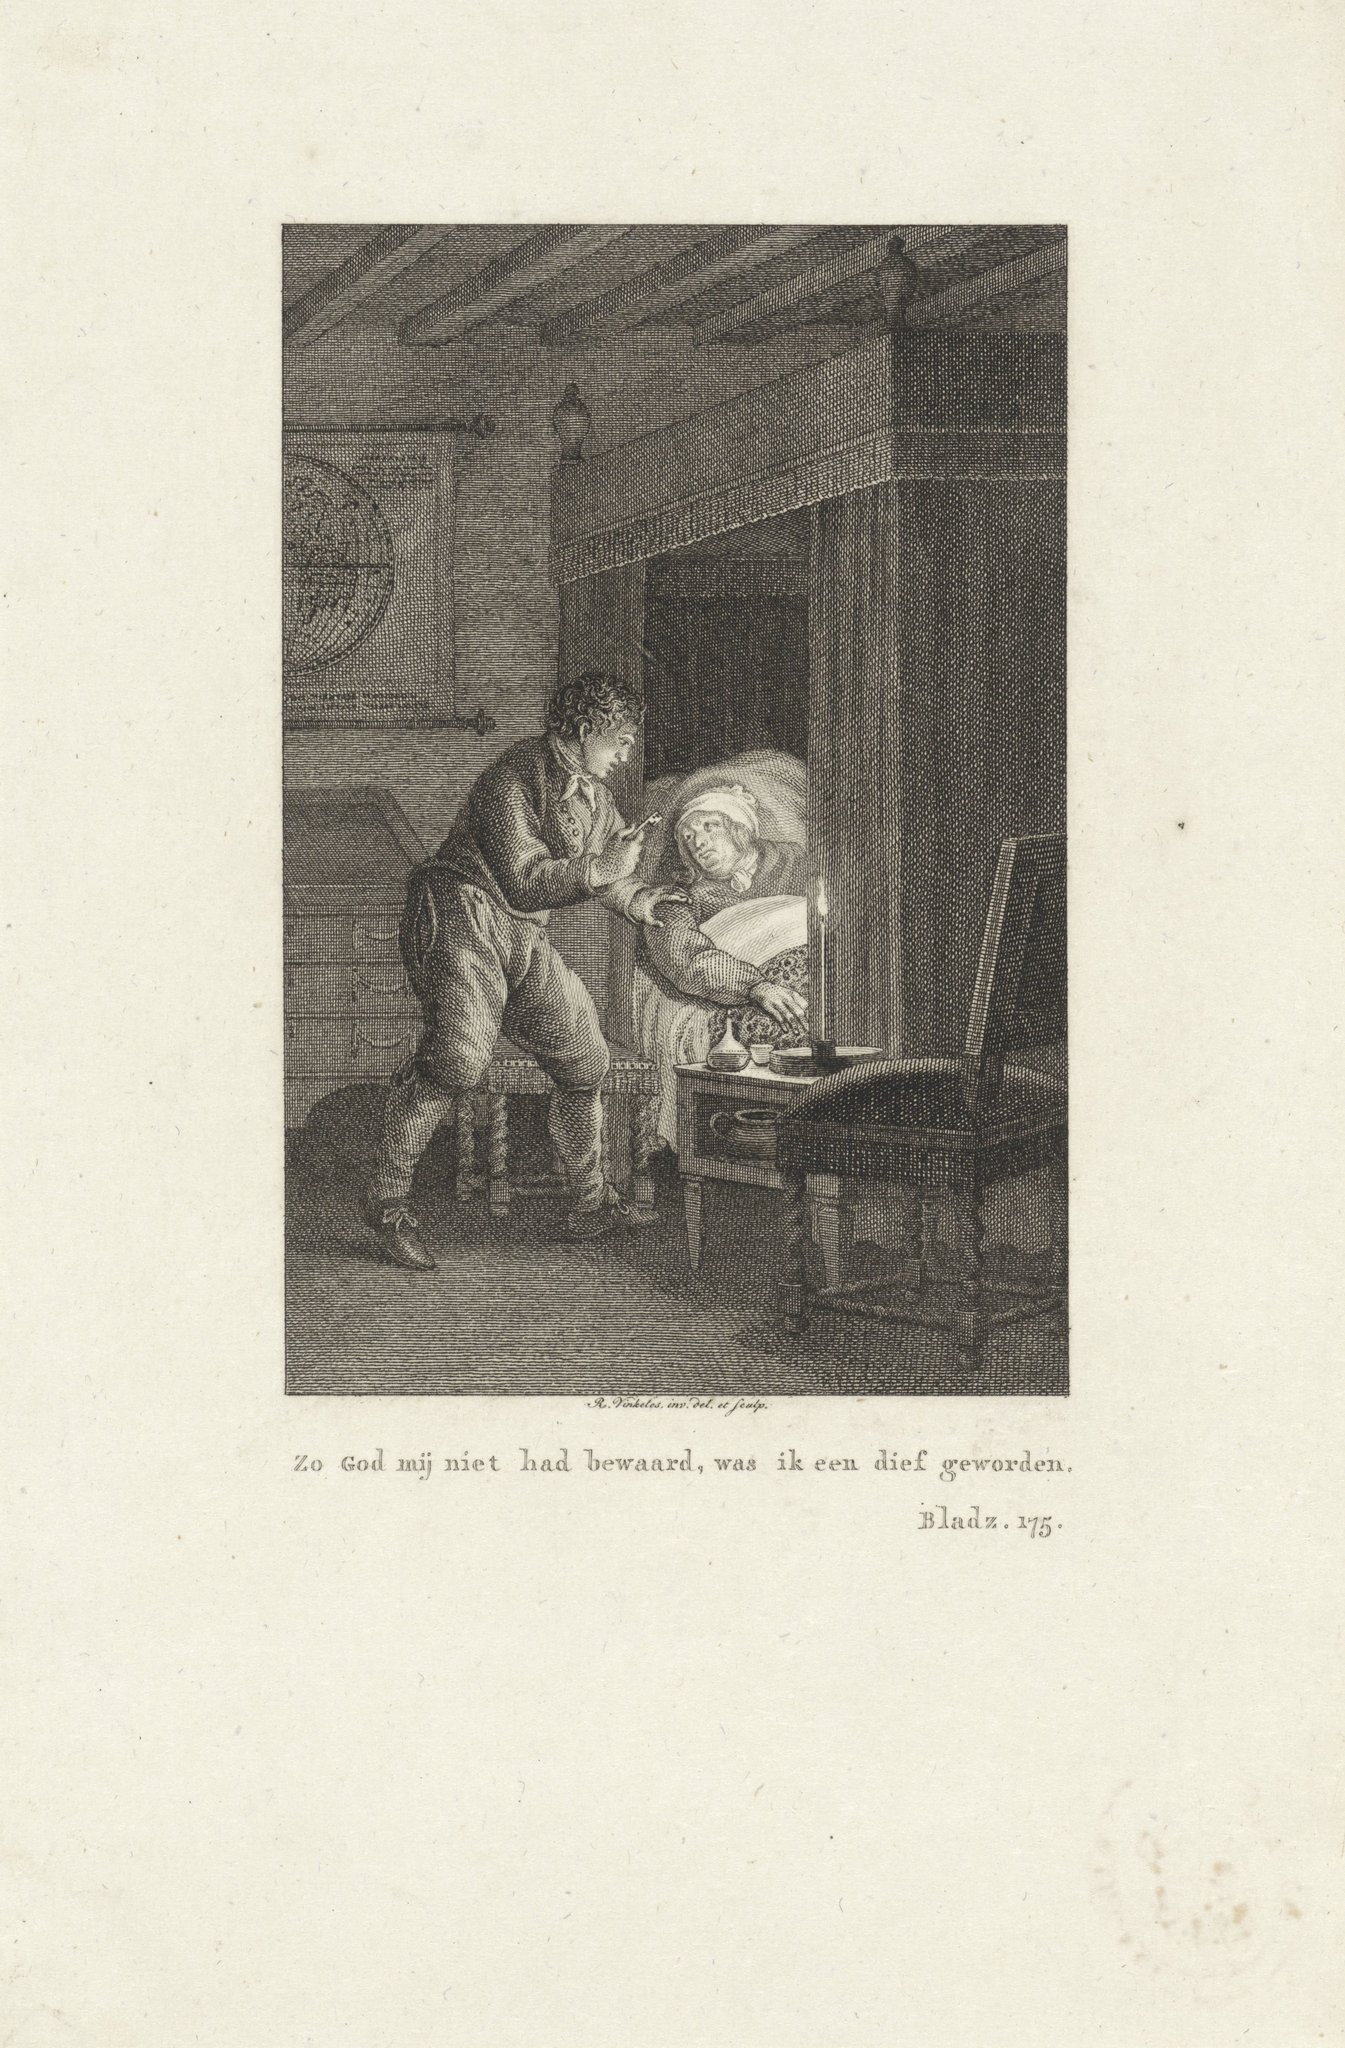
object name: print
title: Man toont een sleutel aan een oude man die in bed ligt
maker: reinier vinkeles (i)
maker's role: draughtsman, print maker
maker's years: 1741-1816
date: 1803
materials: paper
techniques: engraving, etching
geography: amsterdam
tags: key, map of the world, bed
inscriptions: collector's mark: Lugt 2228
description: Deze prent is ook gebruikt als illustratie voor: Loosjes, Adriaan Pietersz. Rijkdom, middelbare stand en armoede: in drie bespiegelingen. Haarlem: Adriaan Pietersz. Loosjes, 1803, p. 175.